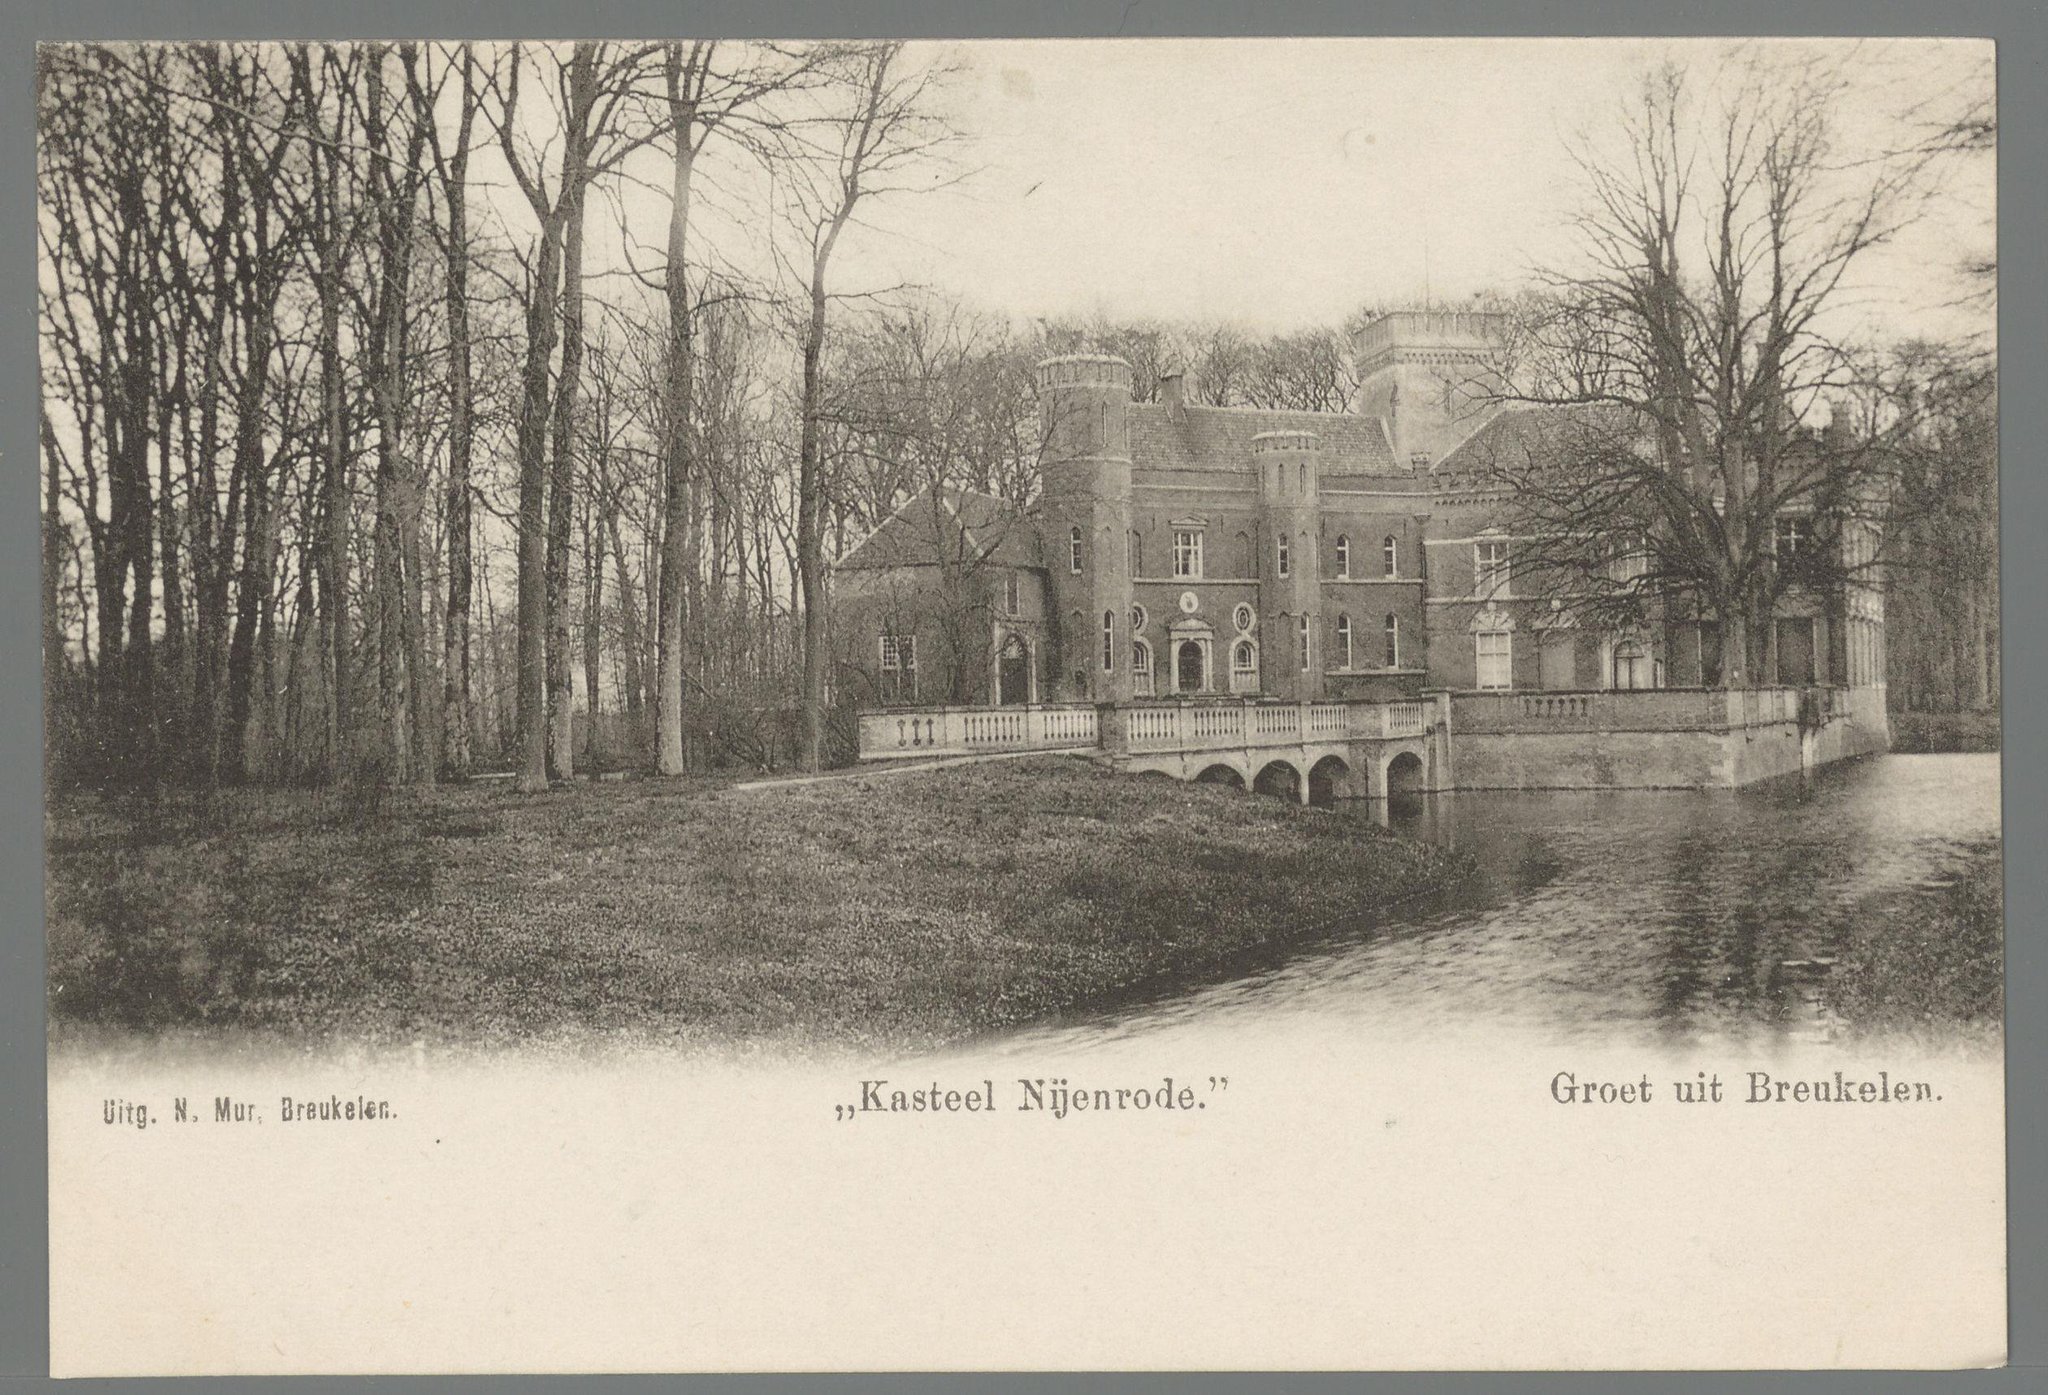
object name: ansichtkaart, prentbriefkaart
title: "Kasteel Nijenrode.". Groet uit Breukelen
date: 1897-1905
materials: cardboard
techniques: photograph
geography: breukelen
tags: castle, pond